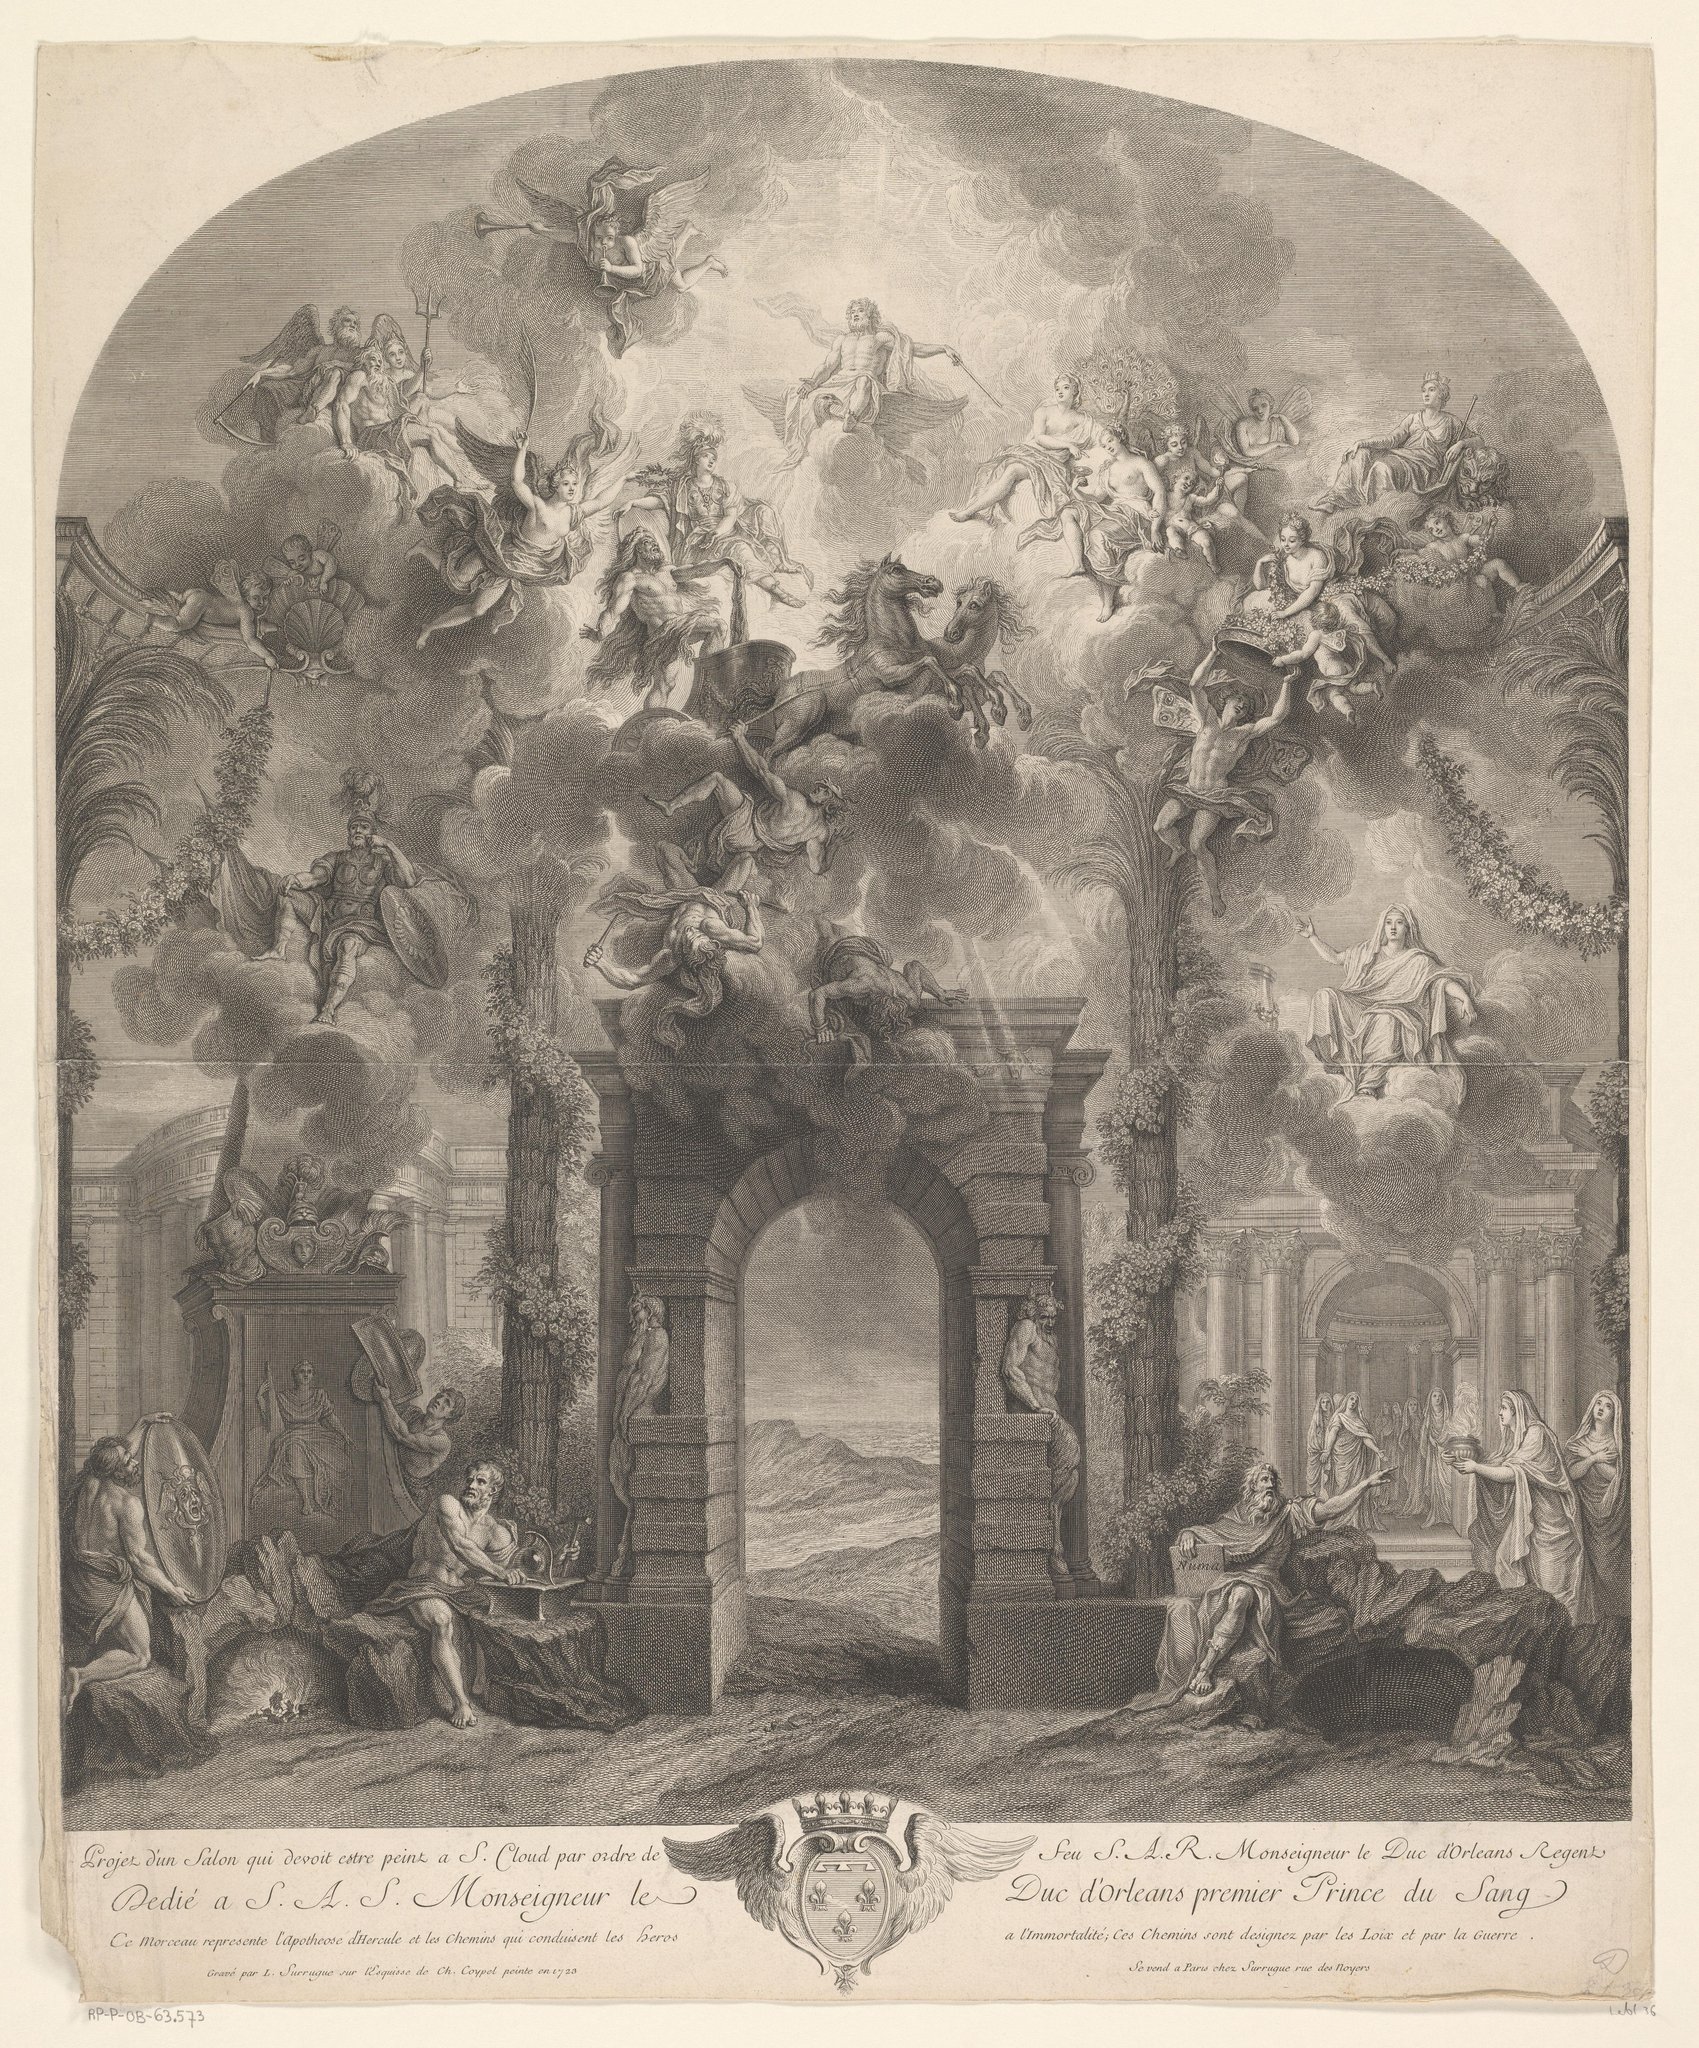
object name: print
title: Projet d'un Salon qui devoit estre peint a S. Cloud (...)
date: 1723-1752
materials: paper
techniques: engraving, etching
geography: paris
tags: apotheosis of hercules: he is borne to heaven in a four-horse chariot and reconciled with juno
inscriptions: collector's mark: Lugt 240